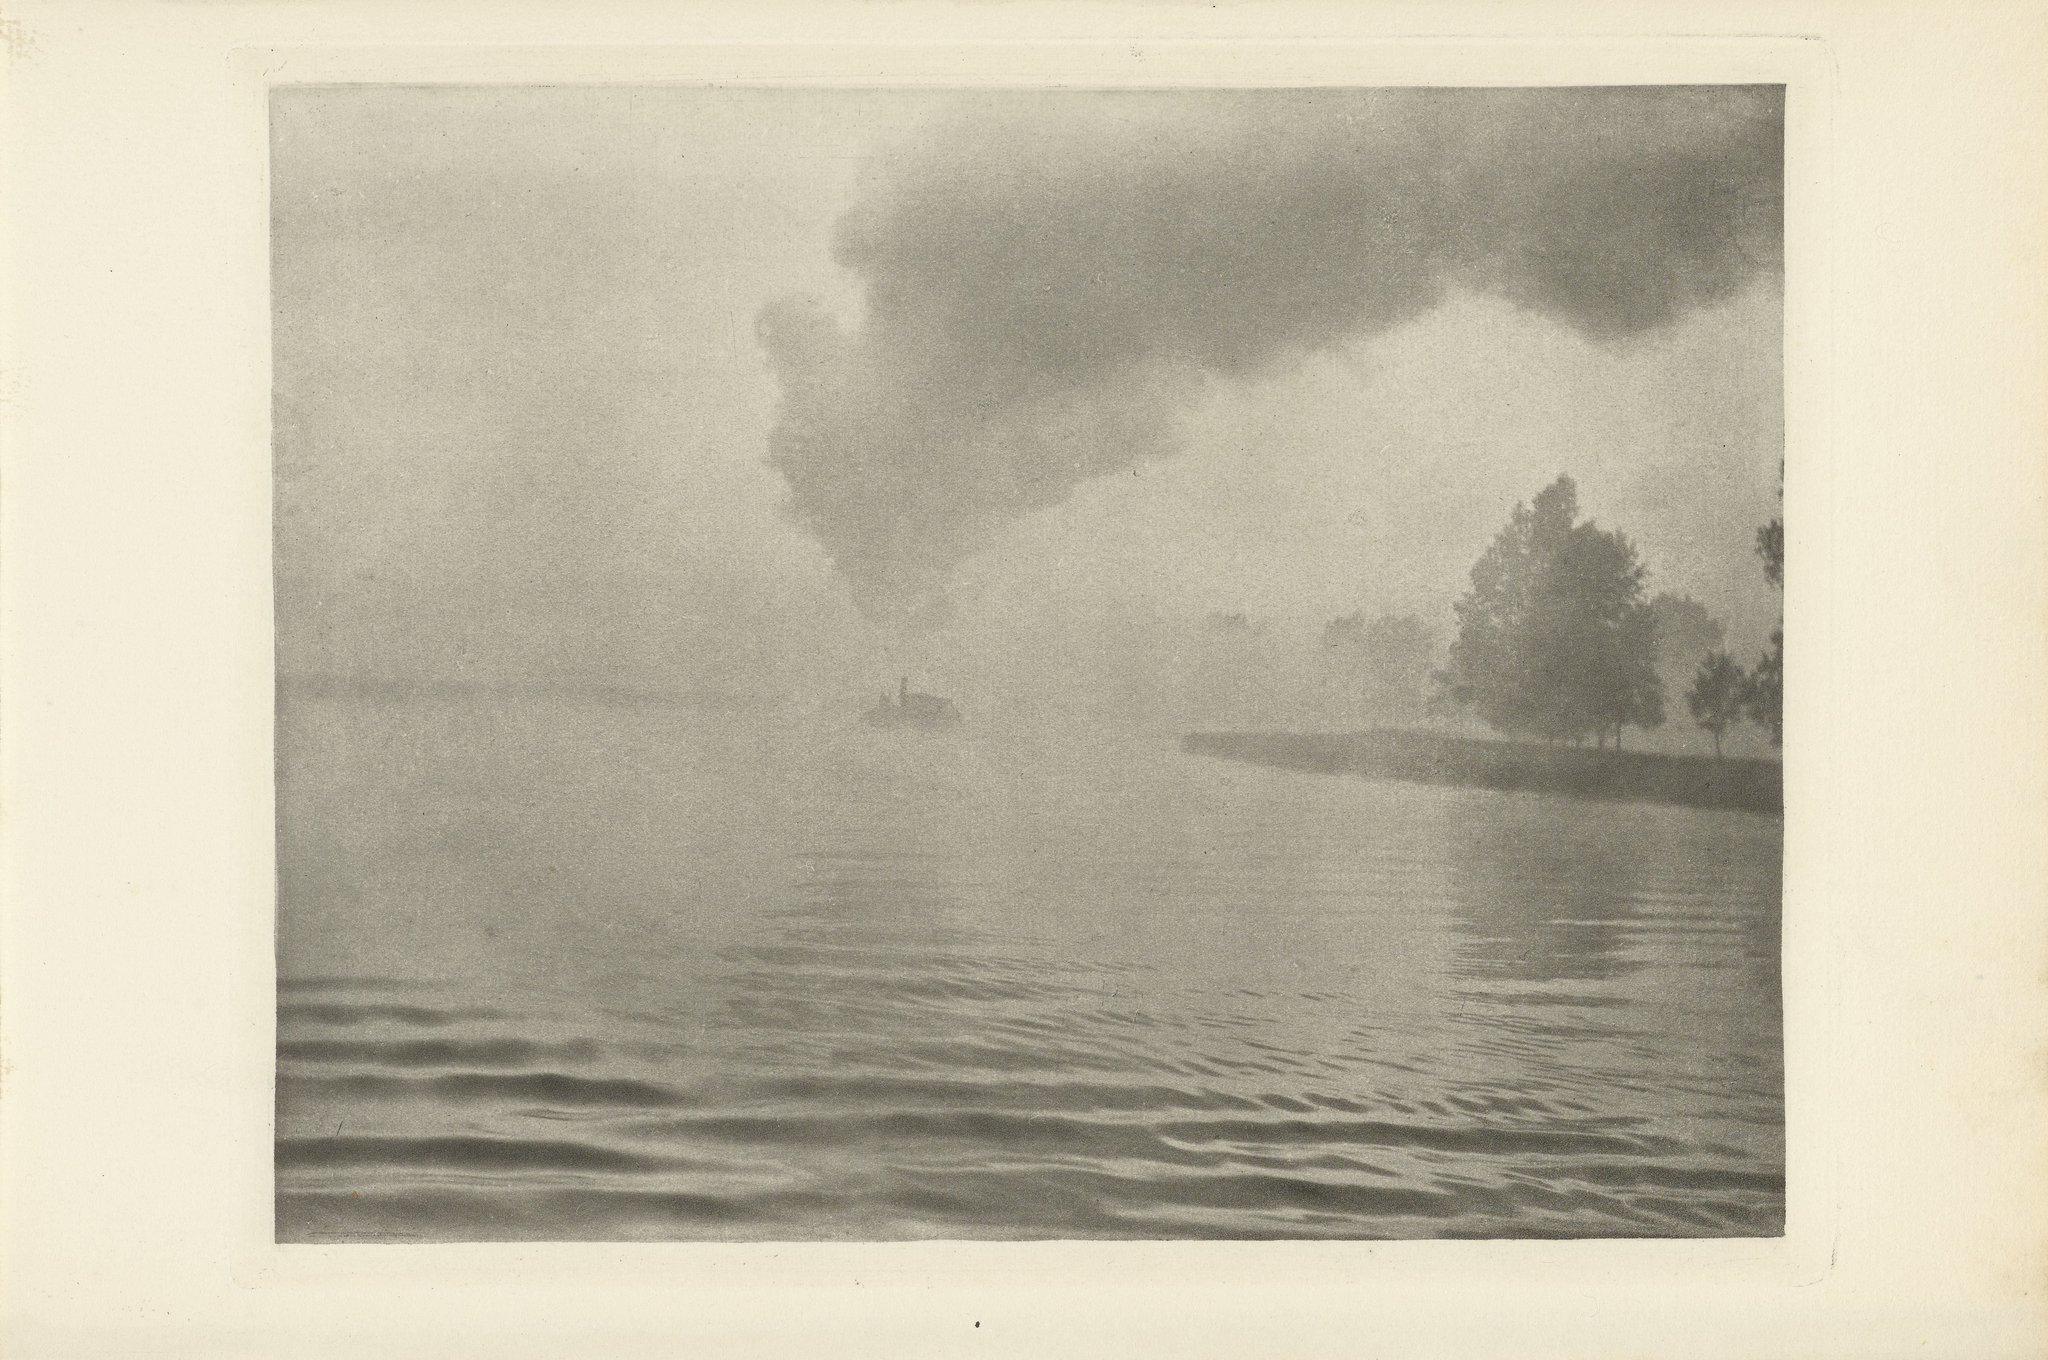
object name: photomechanical print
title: The Misty River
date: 1890-1895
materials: paper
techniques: photoaquatint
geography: great britain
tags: river, steamship, motorship, great britain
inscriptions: inscription: ‘PLATE VIII/ THE MISTY RIVER/ To face page 75’